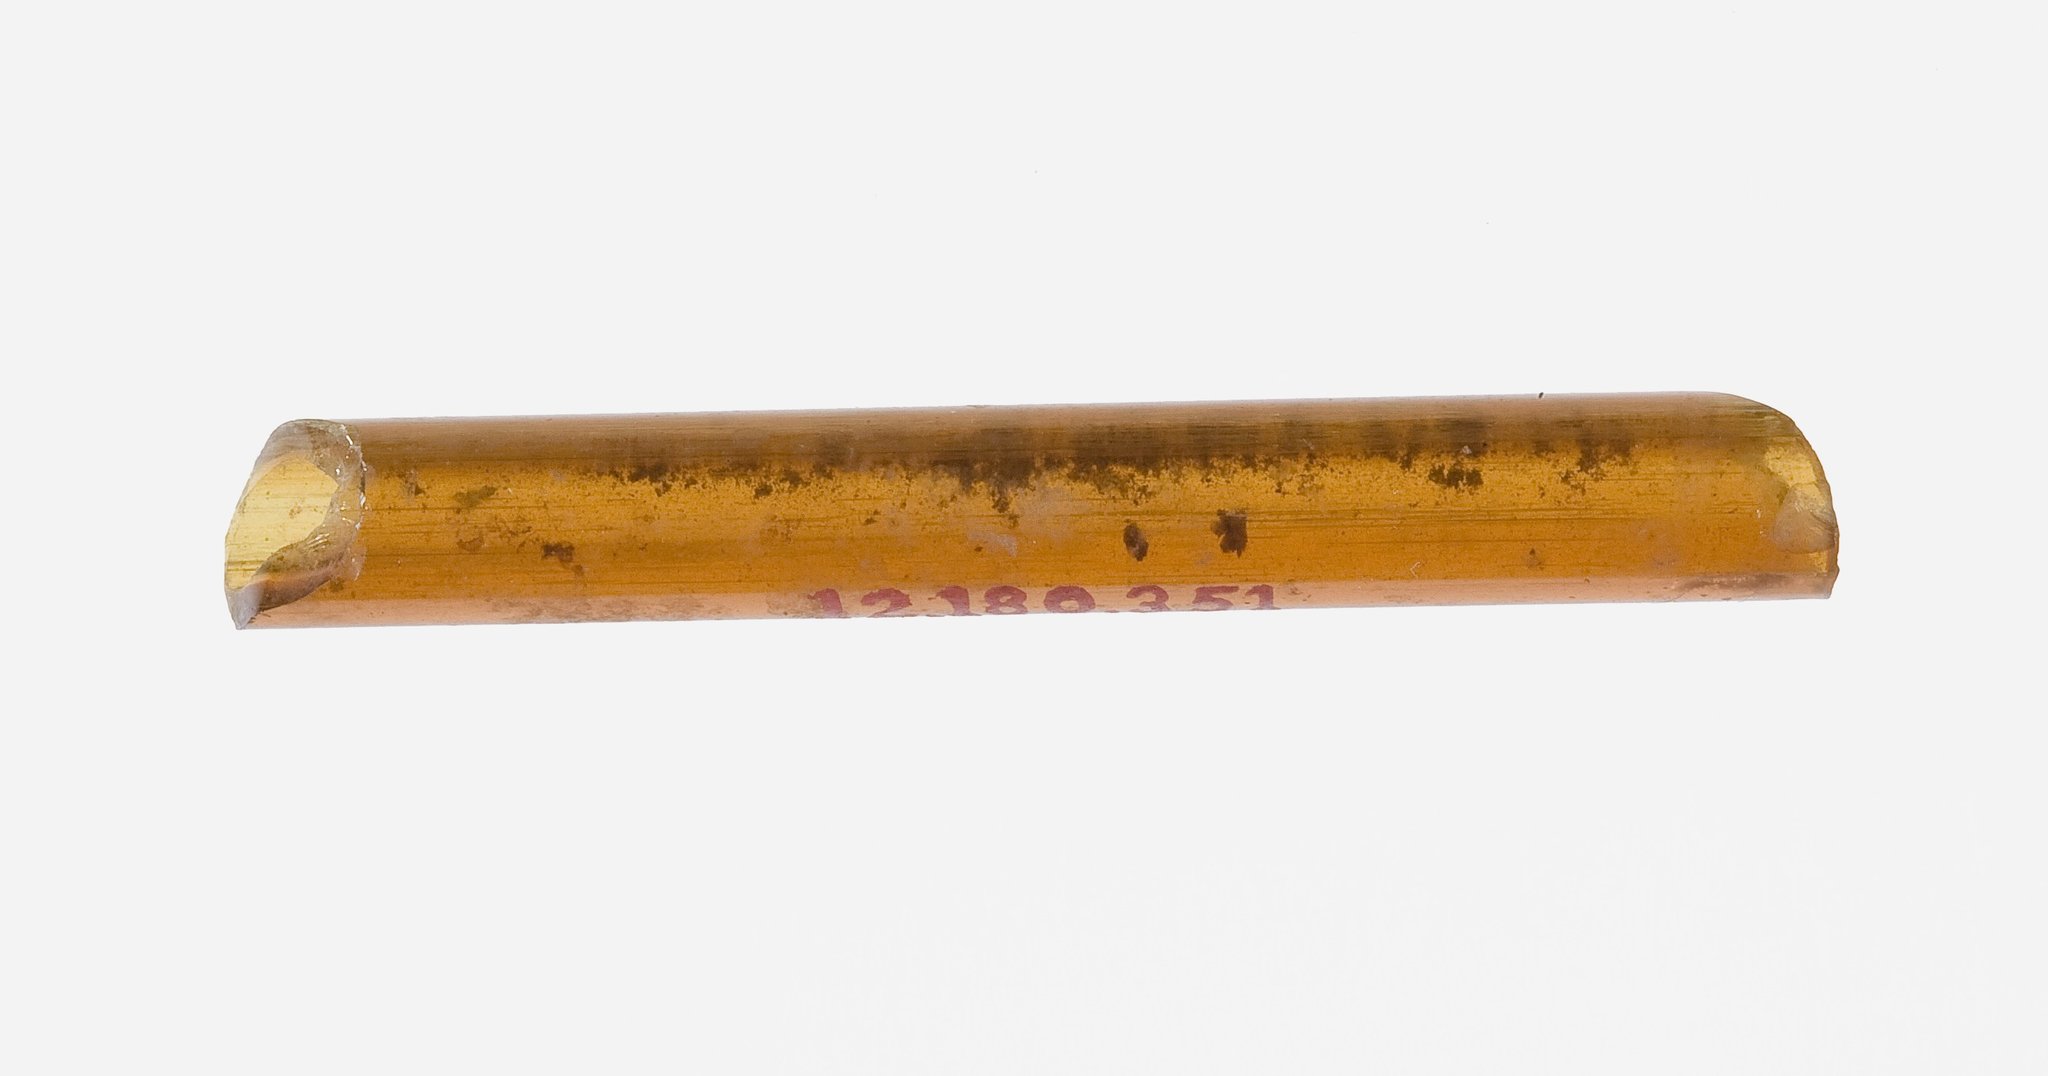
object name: glass rod, yellow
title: Rod of Opaque Yellow Glass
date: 1390-1352 BCE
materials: glass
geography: egypt